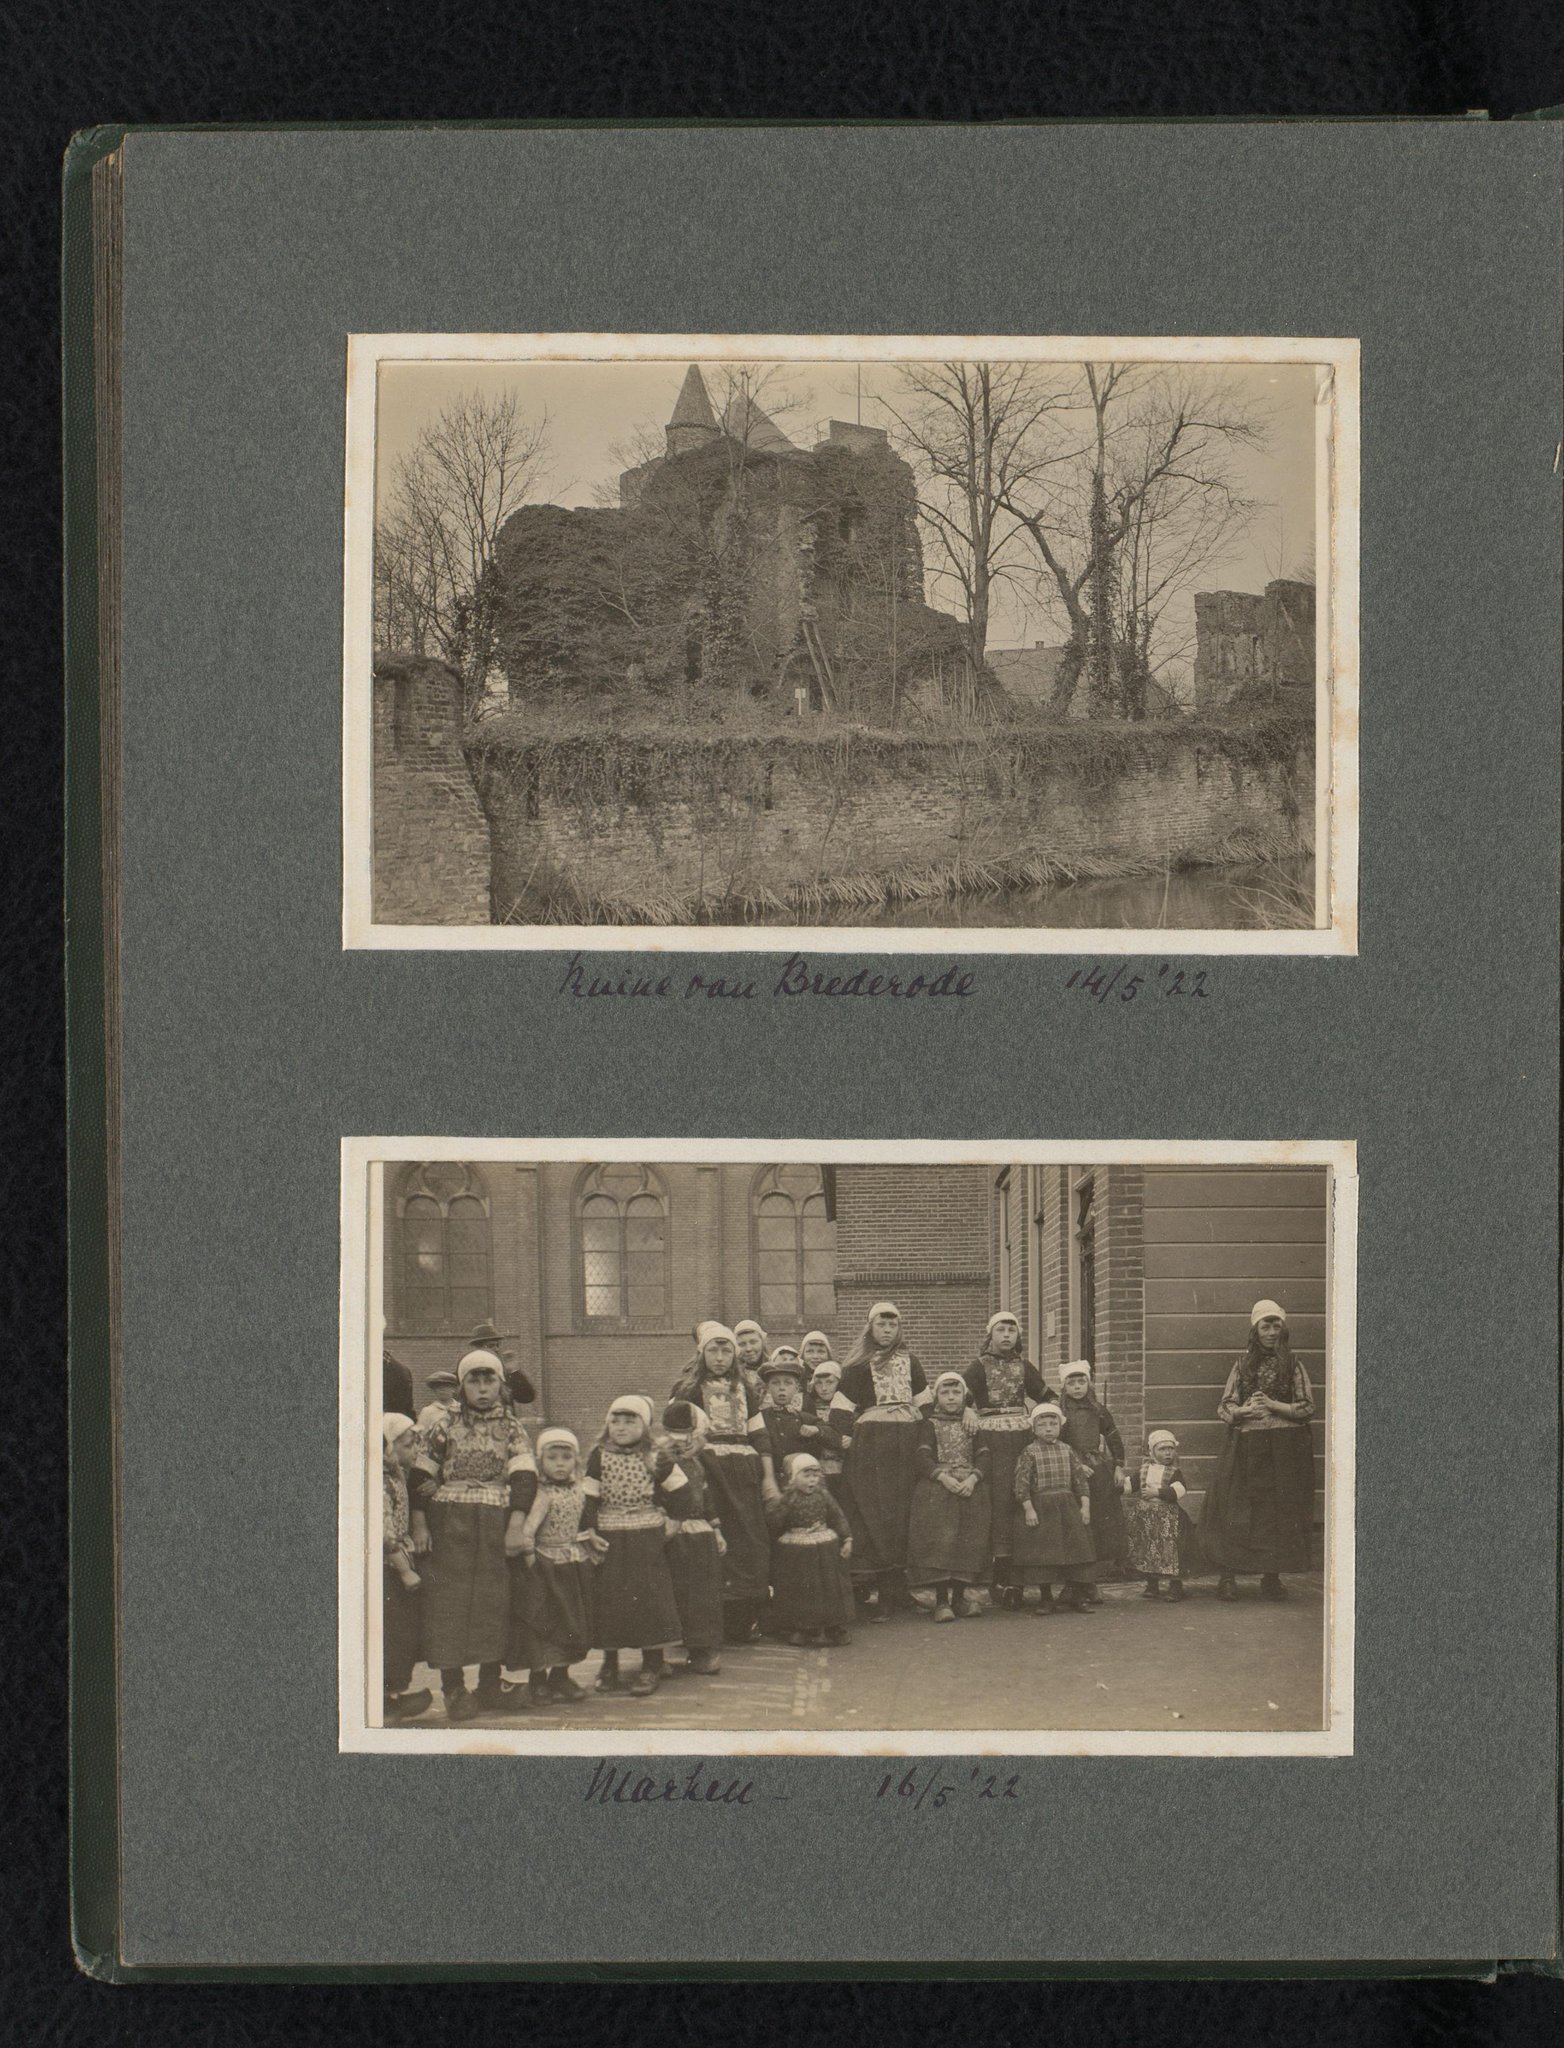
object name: photograph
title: Twee foto's van de ruïne van Brederode en kinderen in lokale dracht in Marken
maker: hendrik herman van den berg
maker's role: amateurfotograaf, jurist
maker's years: 1875-1944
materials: paper, cardboard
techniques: gelatin silver print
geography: north holland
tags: folk costume, regional costume, ruin of a dwelling, house, castle, etc., anonymous historical persons portrayed in a group, in a group-portrait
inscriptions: caption: ‘Ruine van Brederode 14/5 '22/ Marken 16/5 '22’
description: Deze foto's maken deel uit van een album.